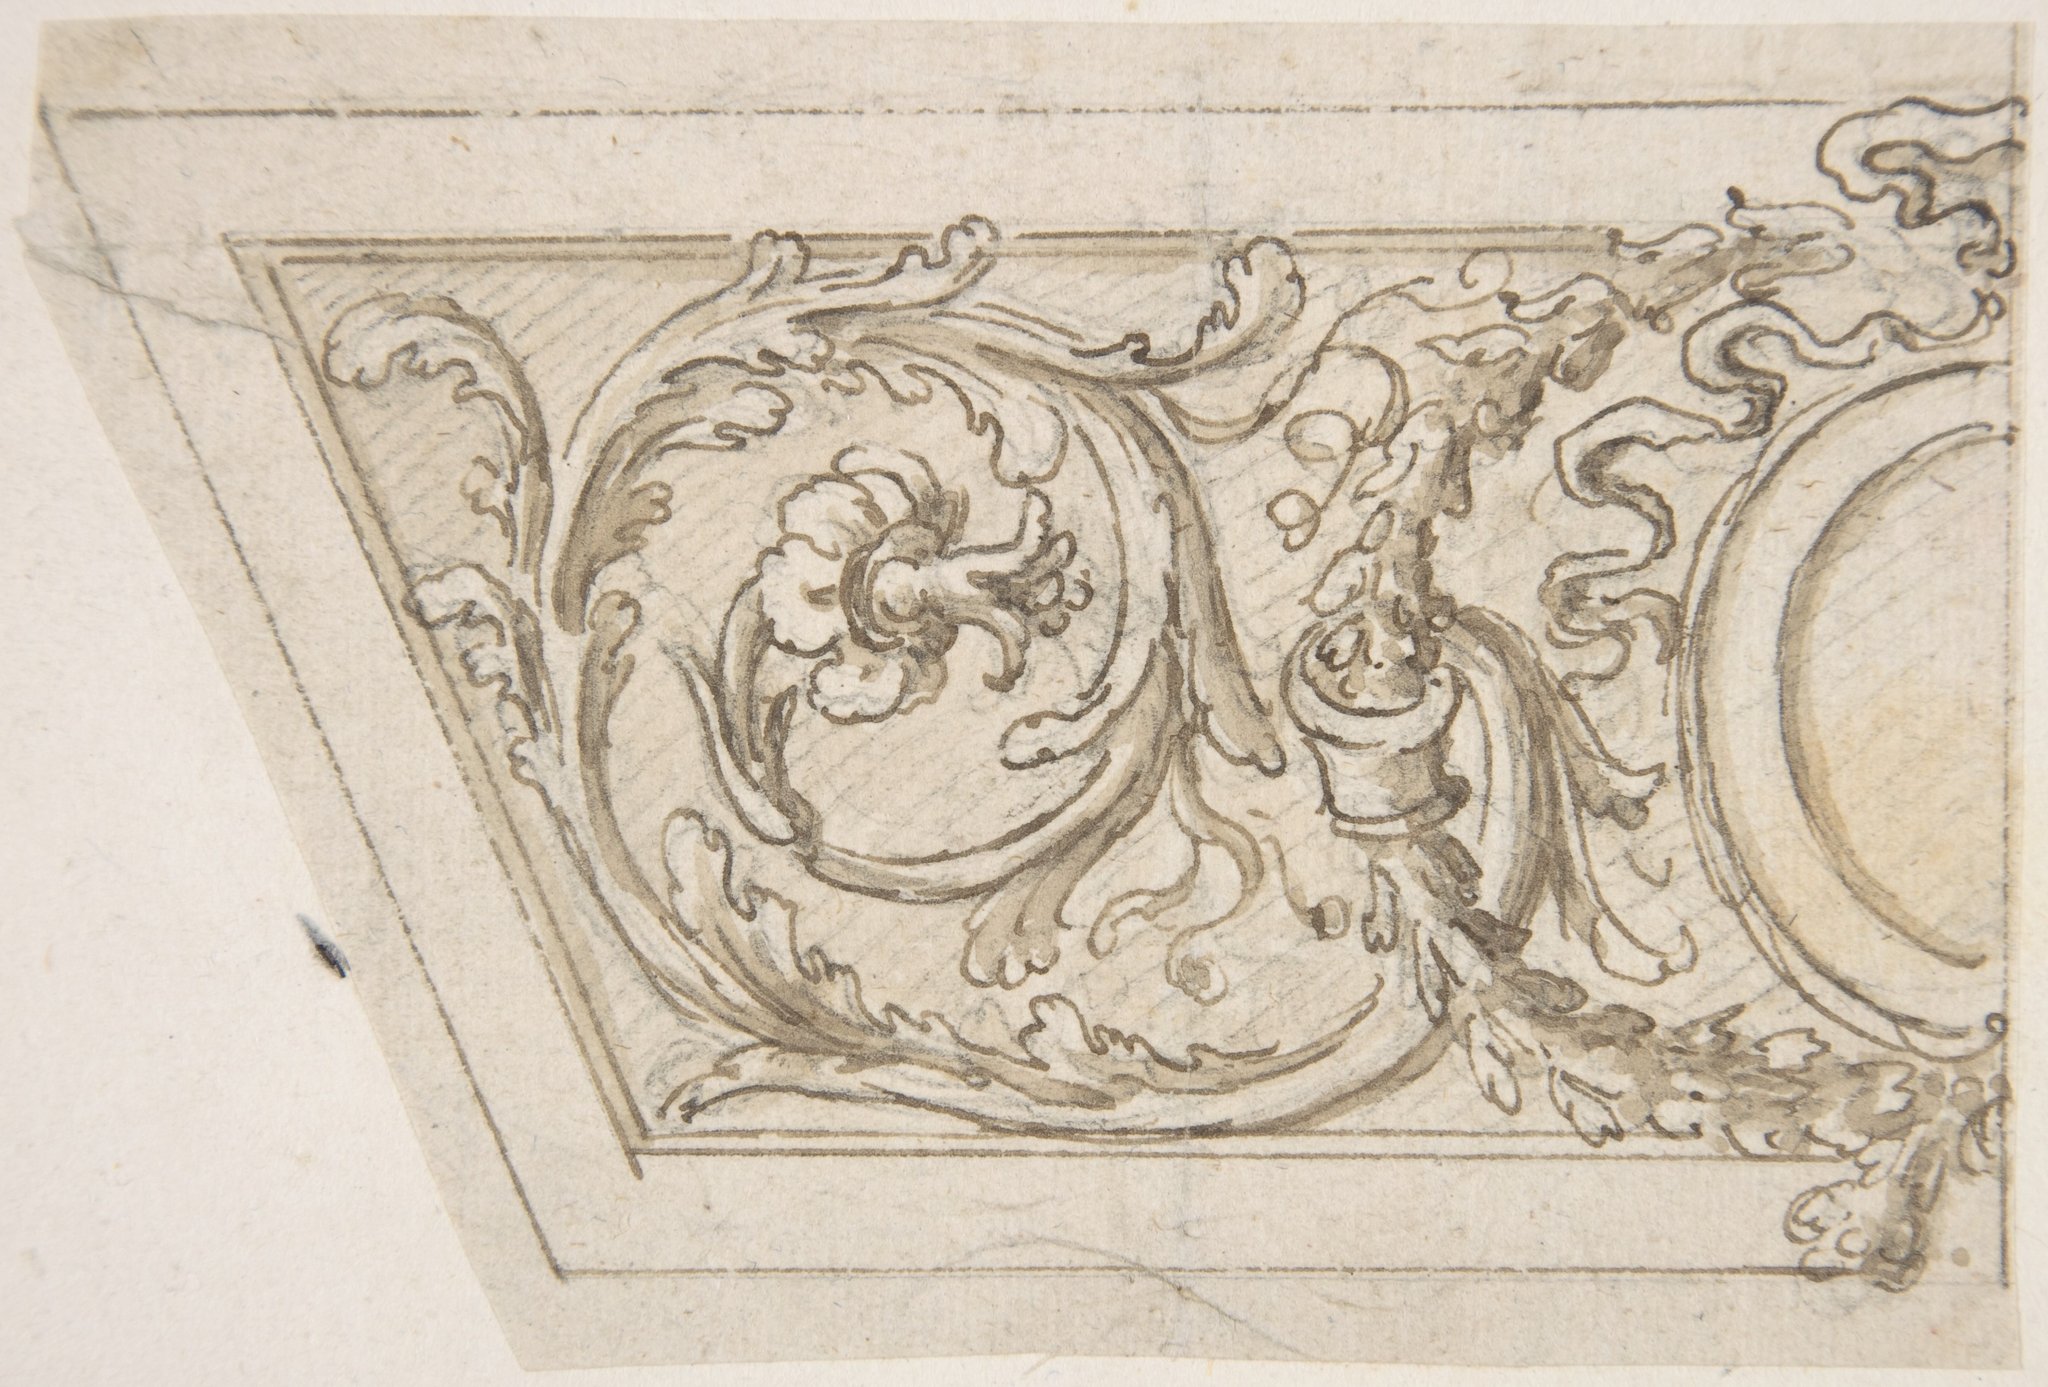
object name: drawing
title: Left Side of a Panel Decorated with Acanthus Scrolls and an Oval Medallion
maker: giovanni battista foggini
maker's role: artist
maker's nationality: italian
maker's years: 1652-1725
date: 1672-1725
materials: chalk, ink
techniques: brush, pen, wash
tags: ornament